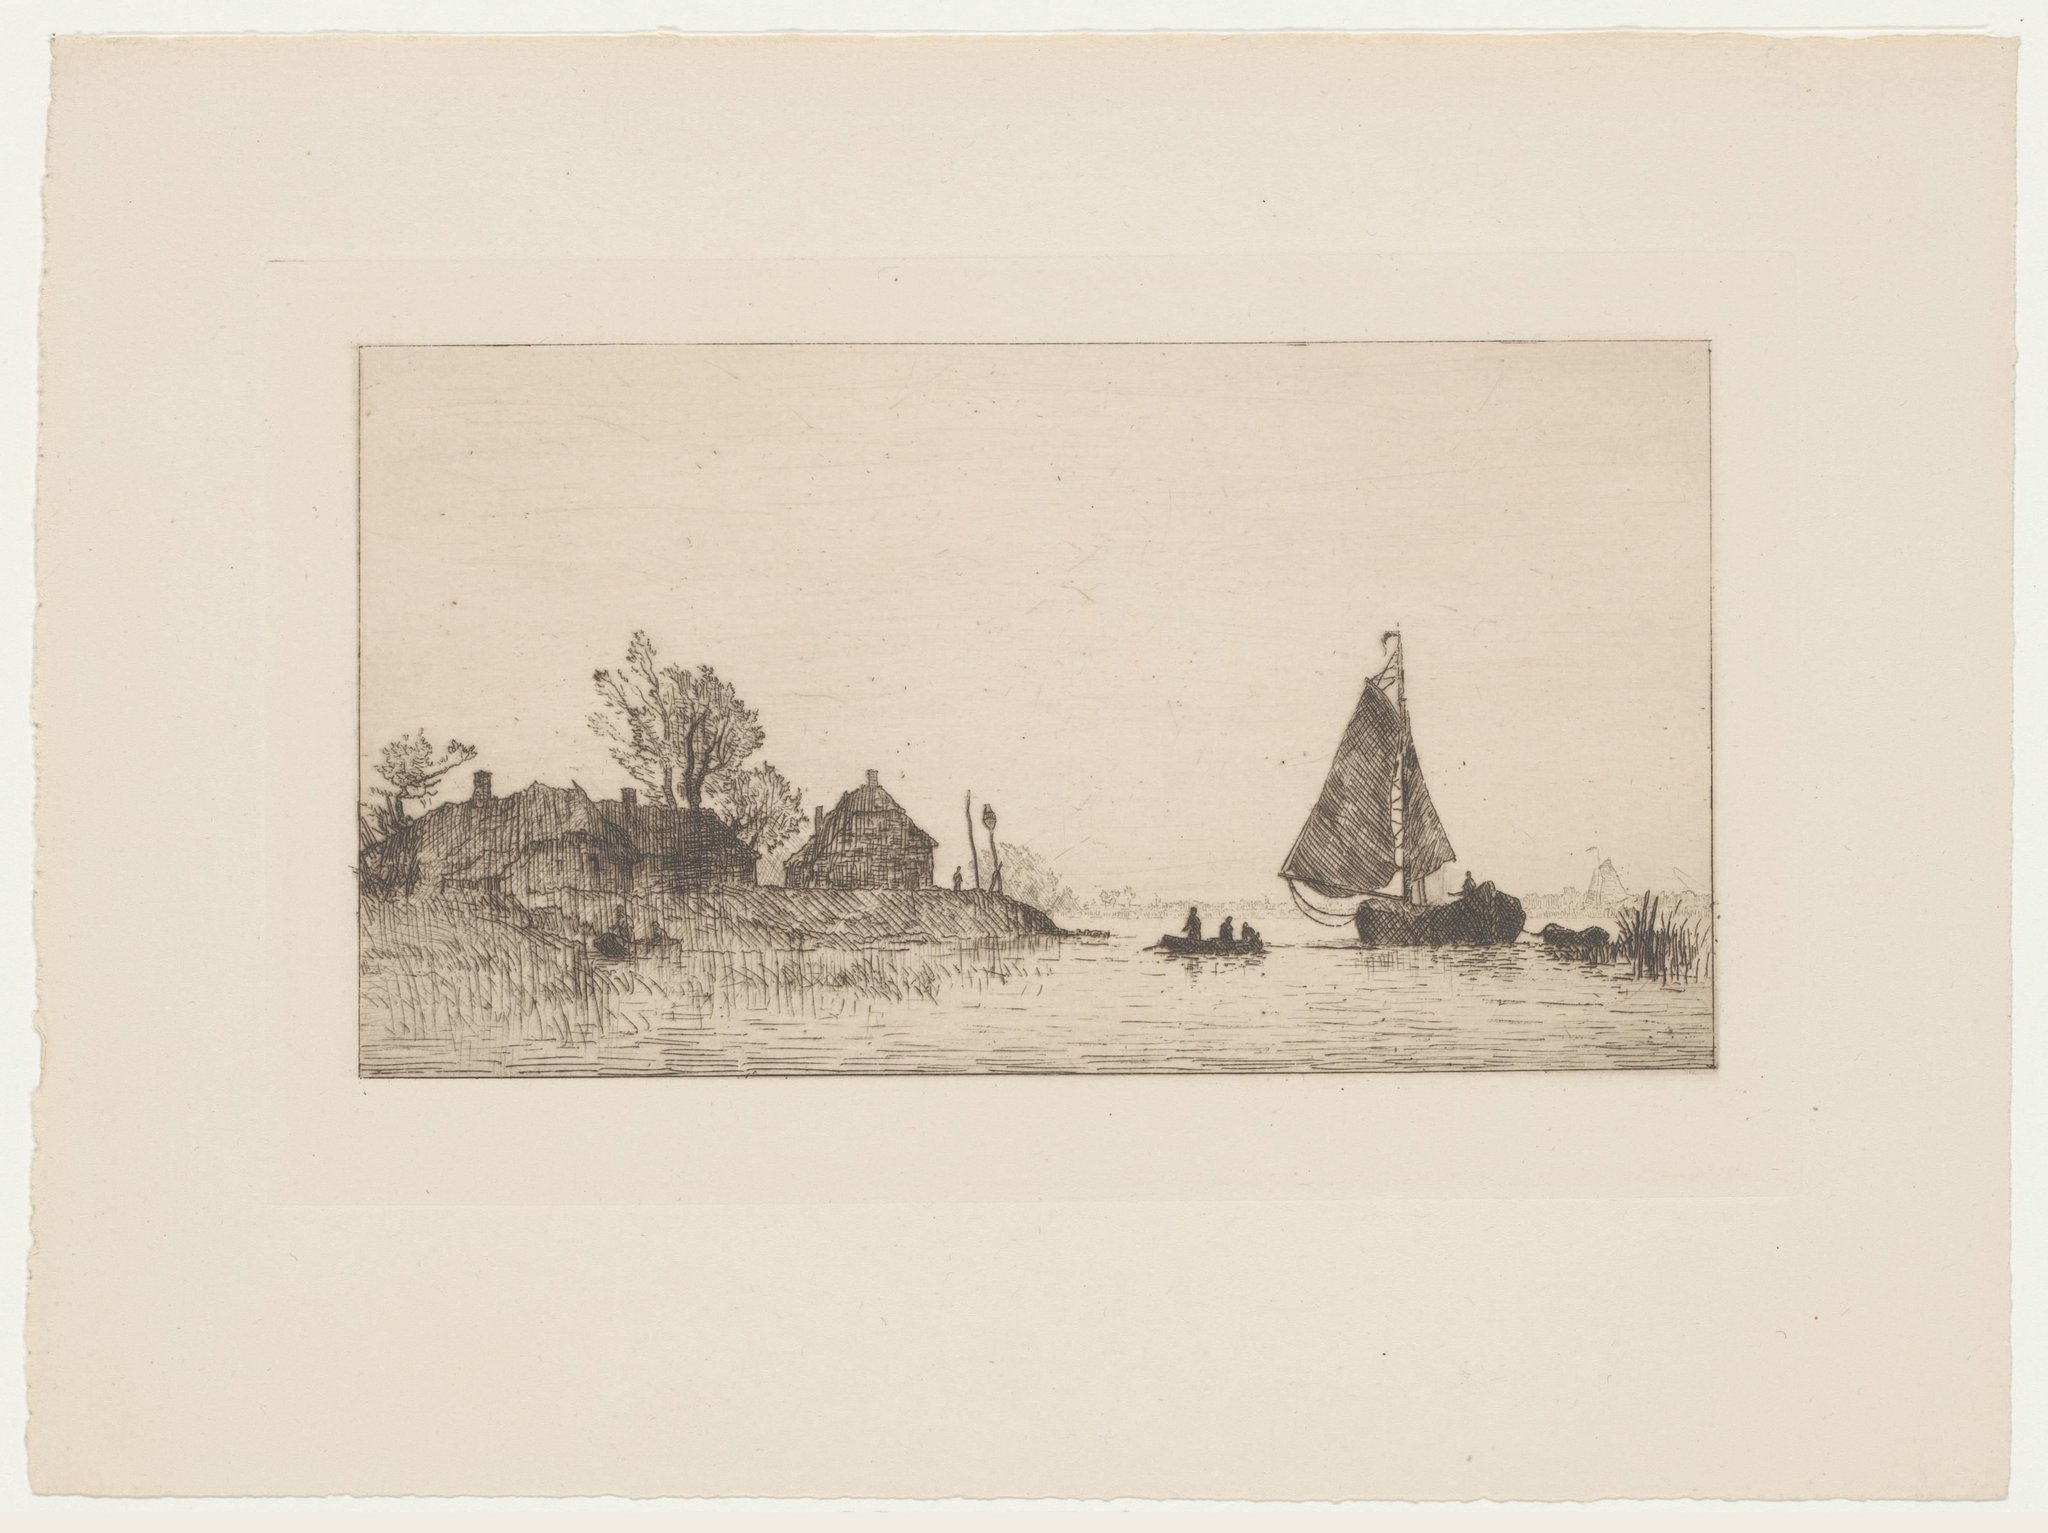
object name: print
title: Rivierlandschap met zeilboot en twee roeiboten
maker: alphonse stengelin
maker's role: painter, print maker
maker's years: 1852-1938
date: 1862-1937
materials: paper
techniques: etching, intaglio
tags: water course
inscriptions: collector's mark: Lugt 2228, collector's mark: Lugt 2760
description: Landschap met enkele huizen aan een rivier, op het water drie boten.